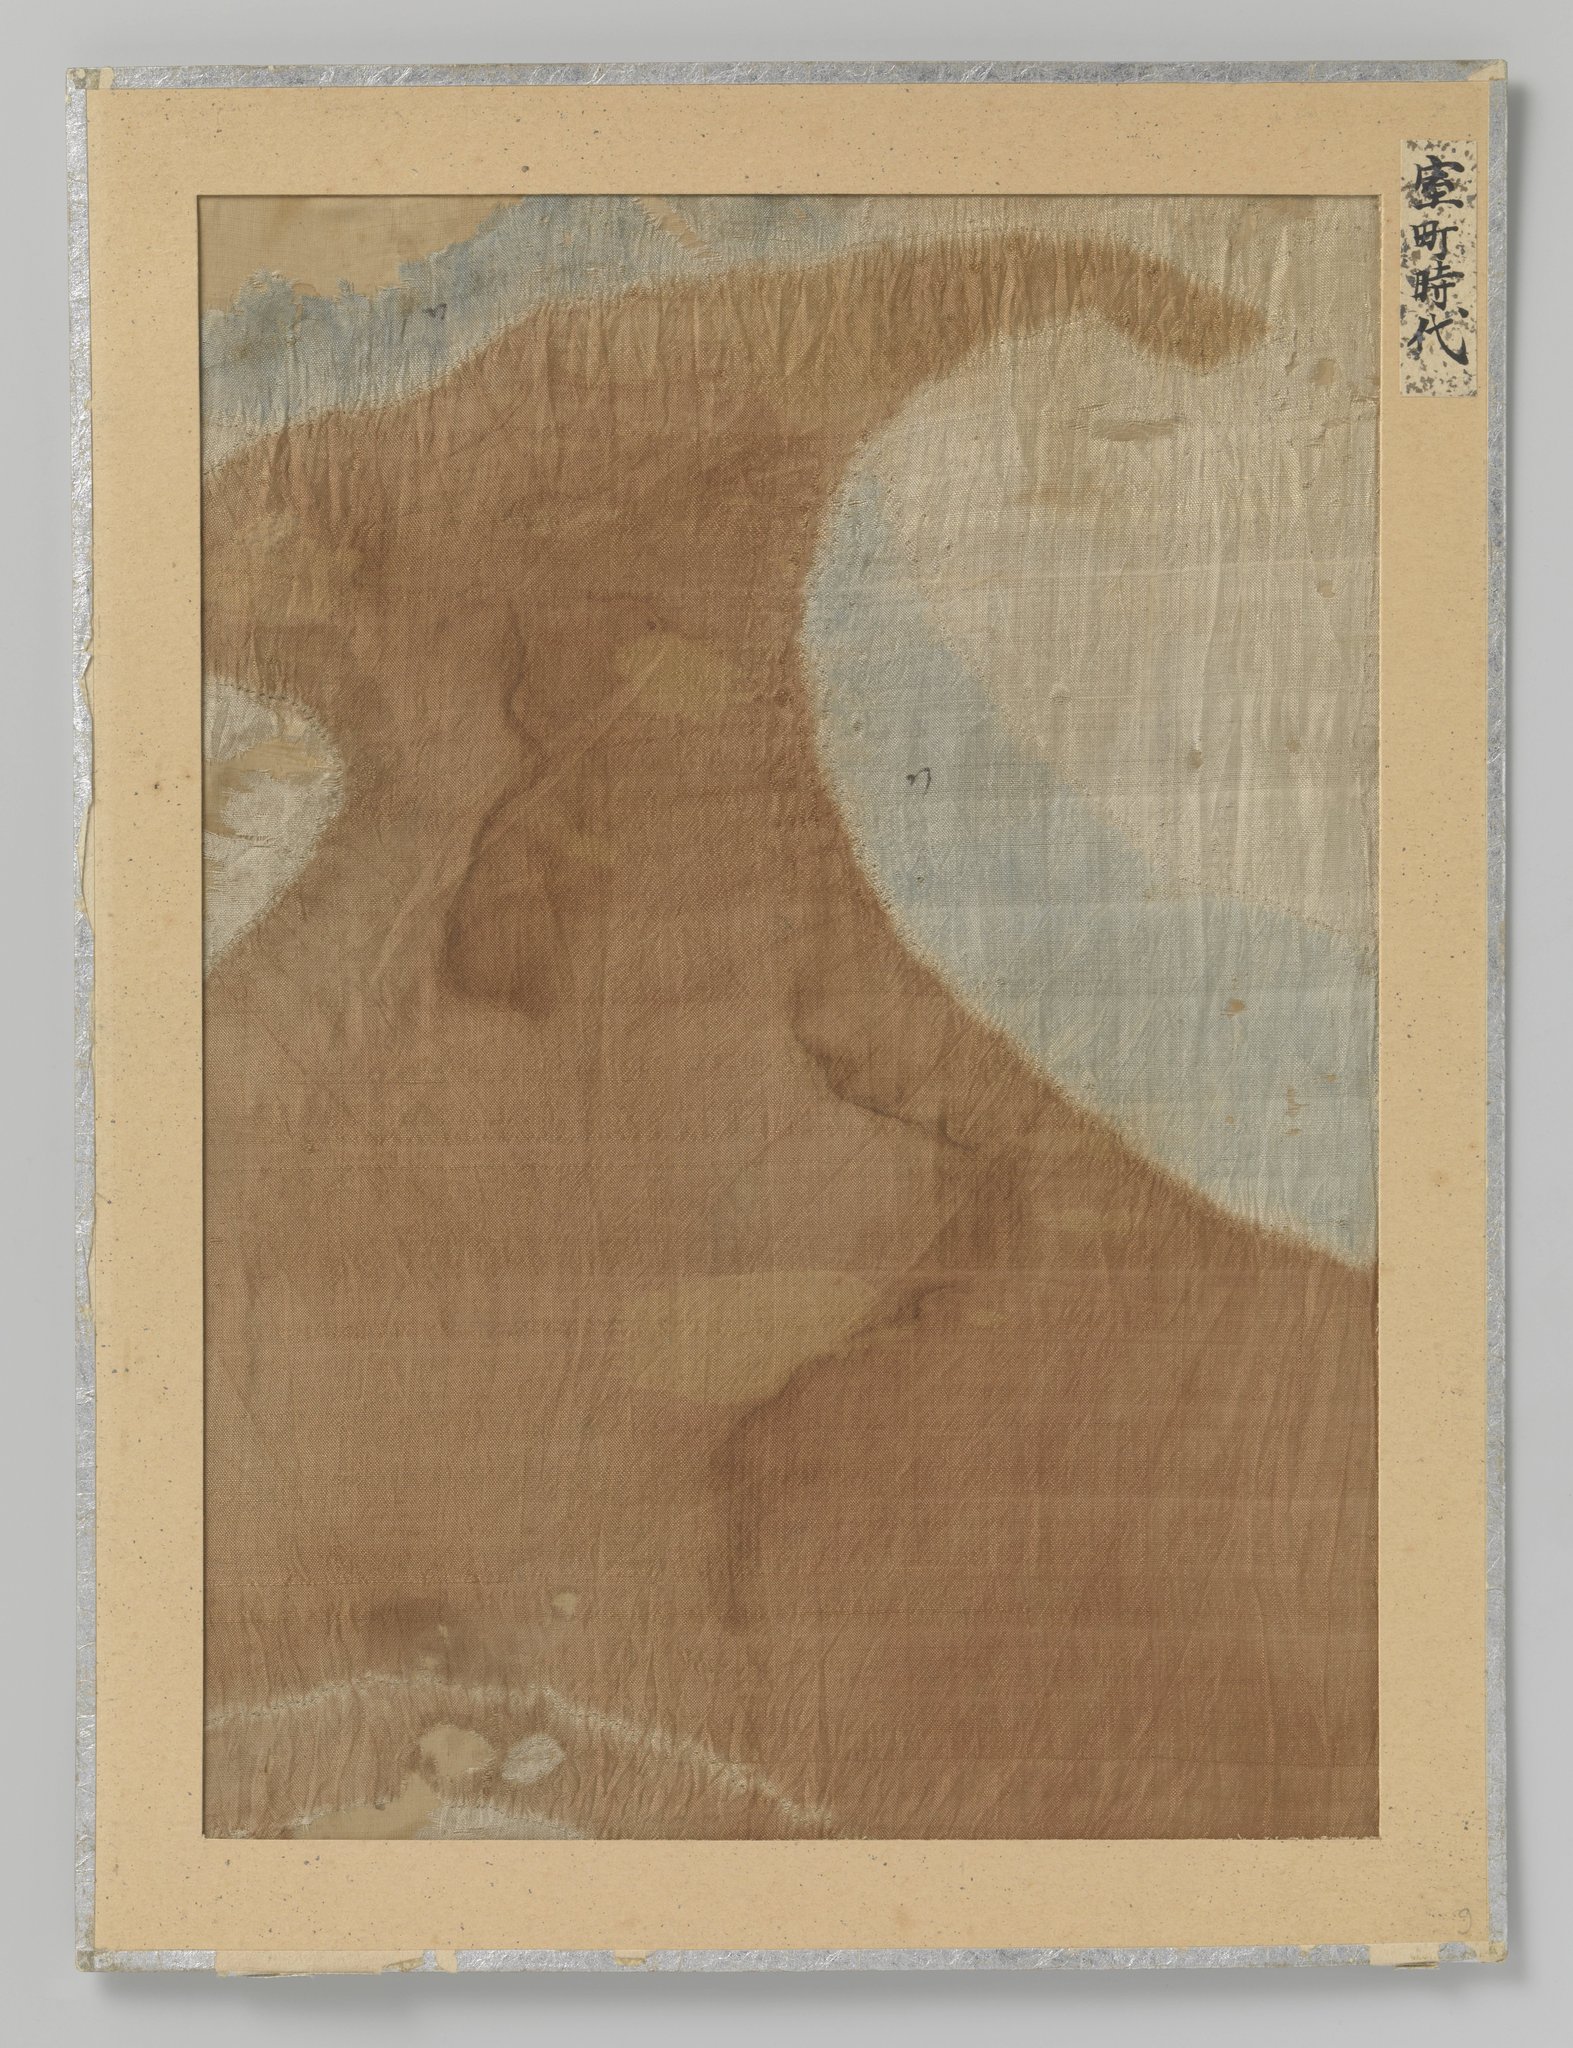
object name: textile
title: Fragment textiel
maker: Anonymous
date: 1336-1469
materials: silk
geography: japan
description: Textielfragment, `afgebonden` techniek op zijde.